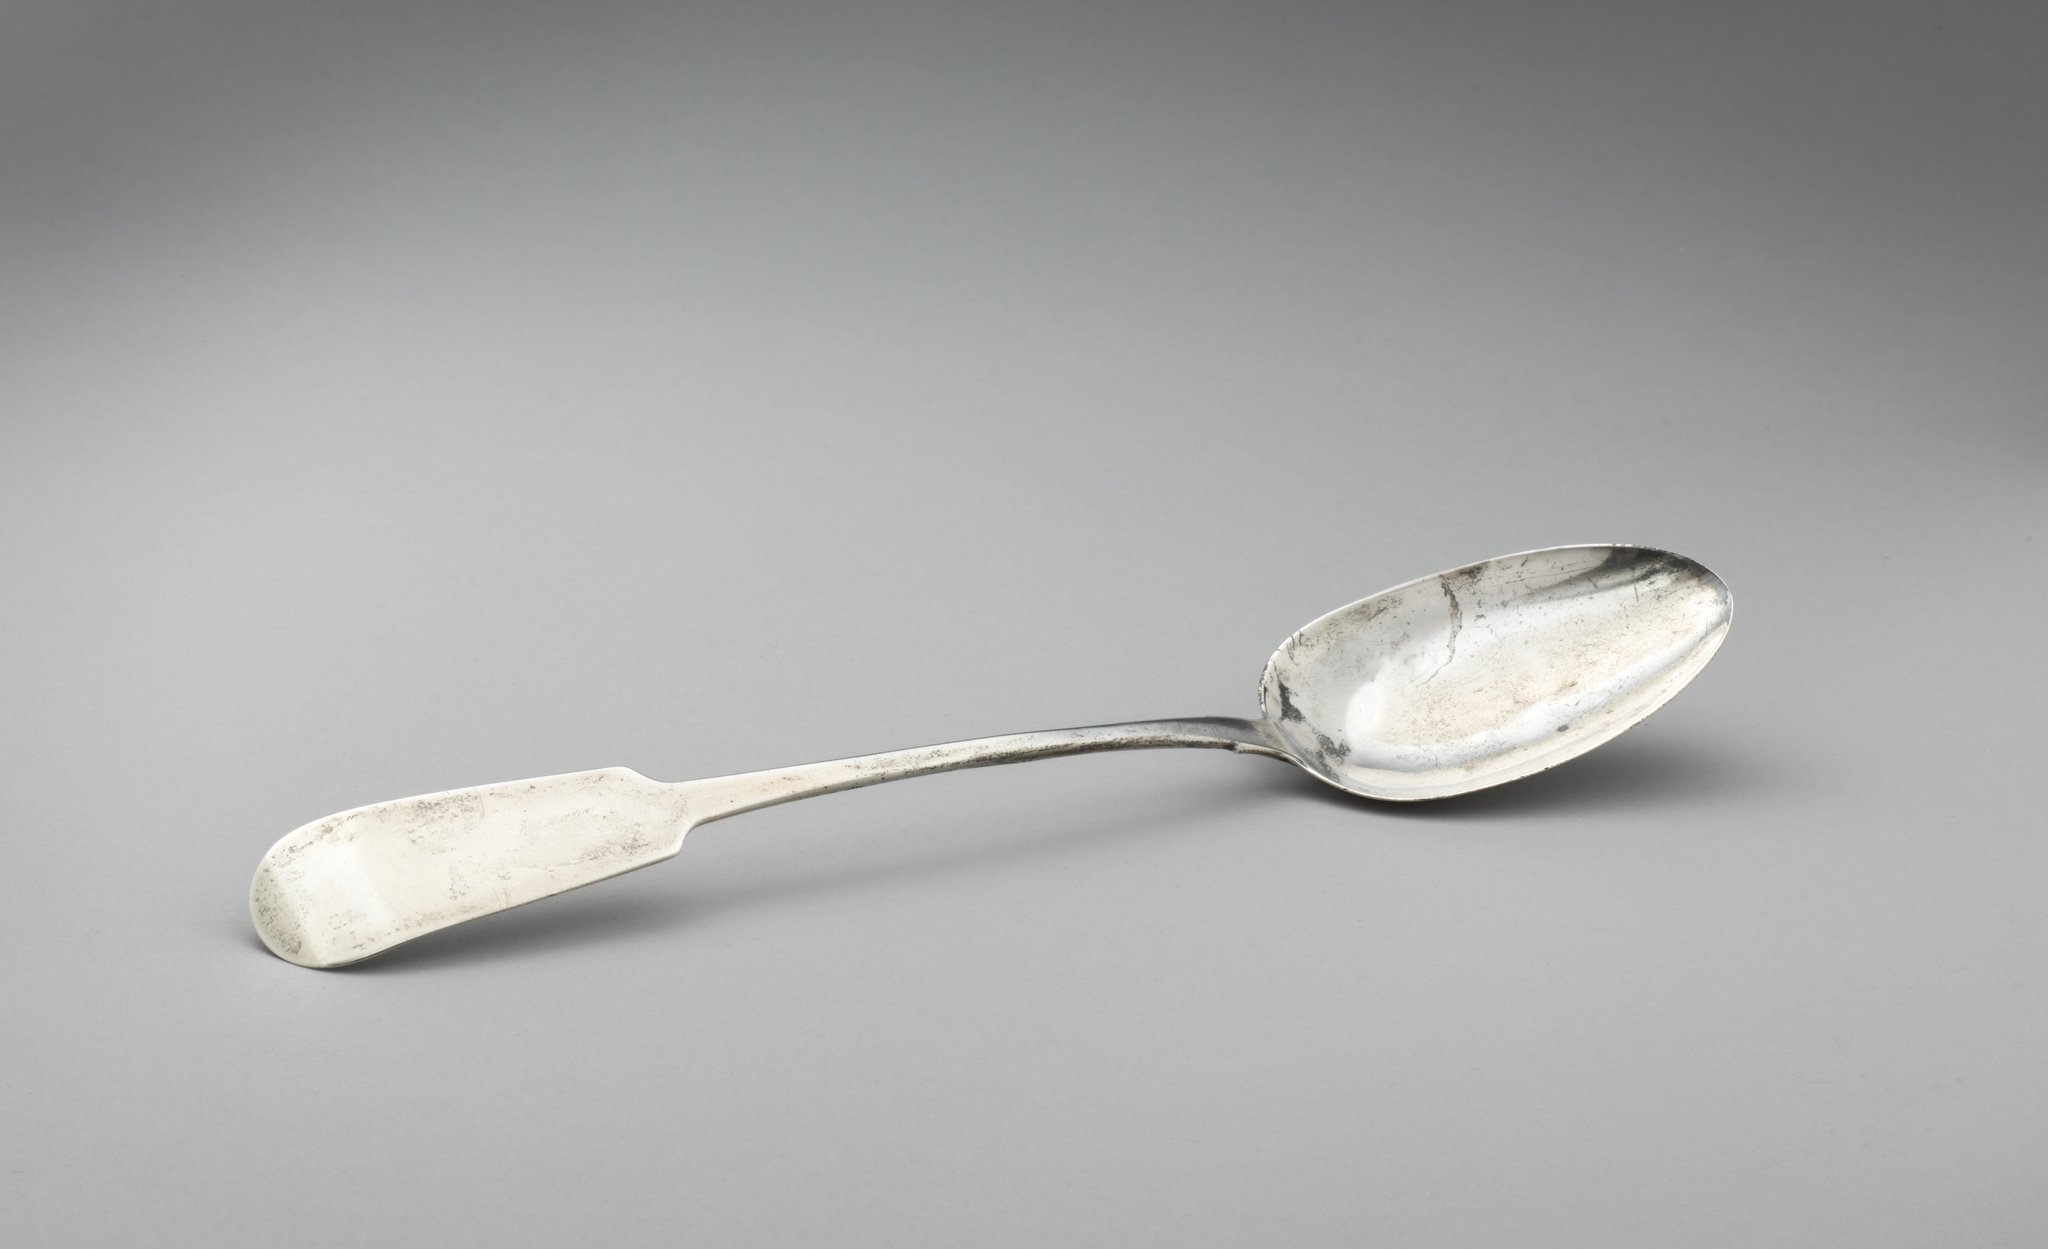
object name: gravy spoon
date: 1701-1800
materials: silver